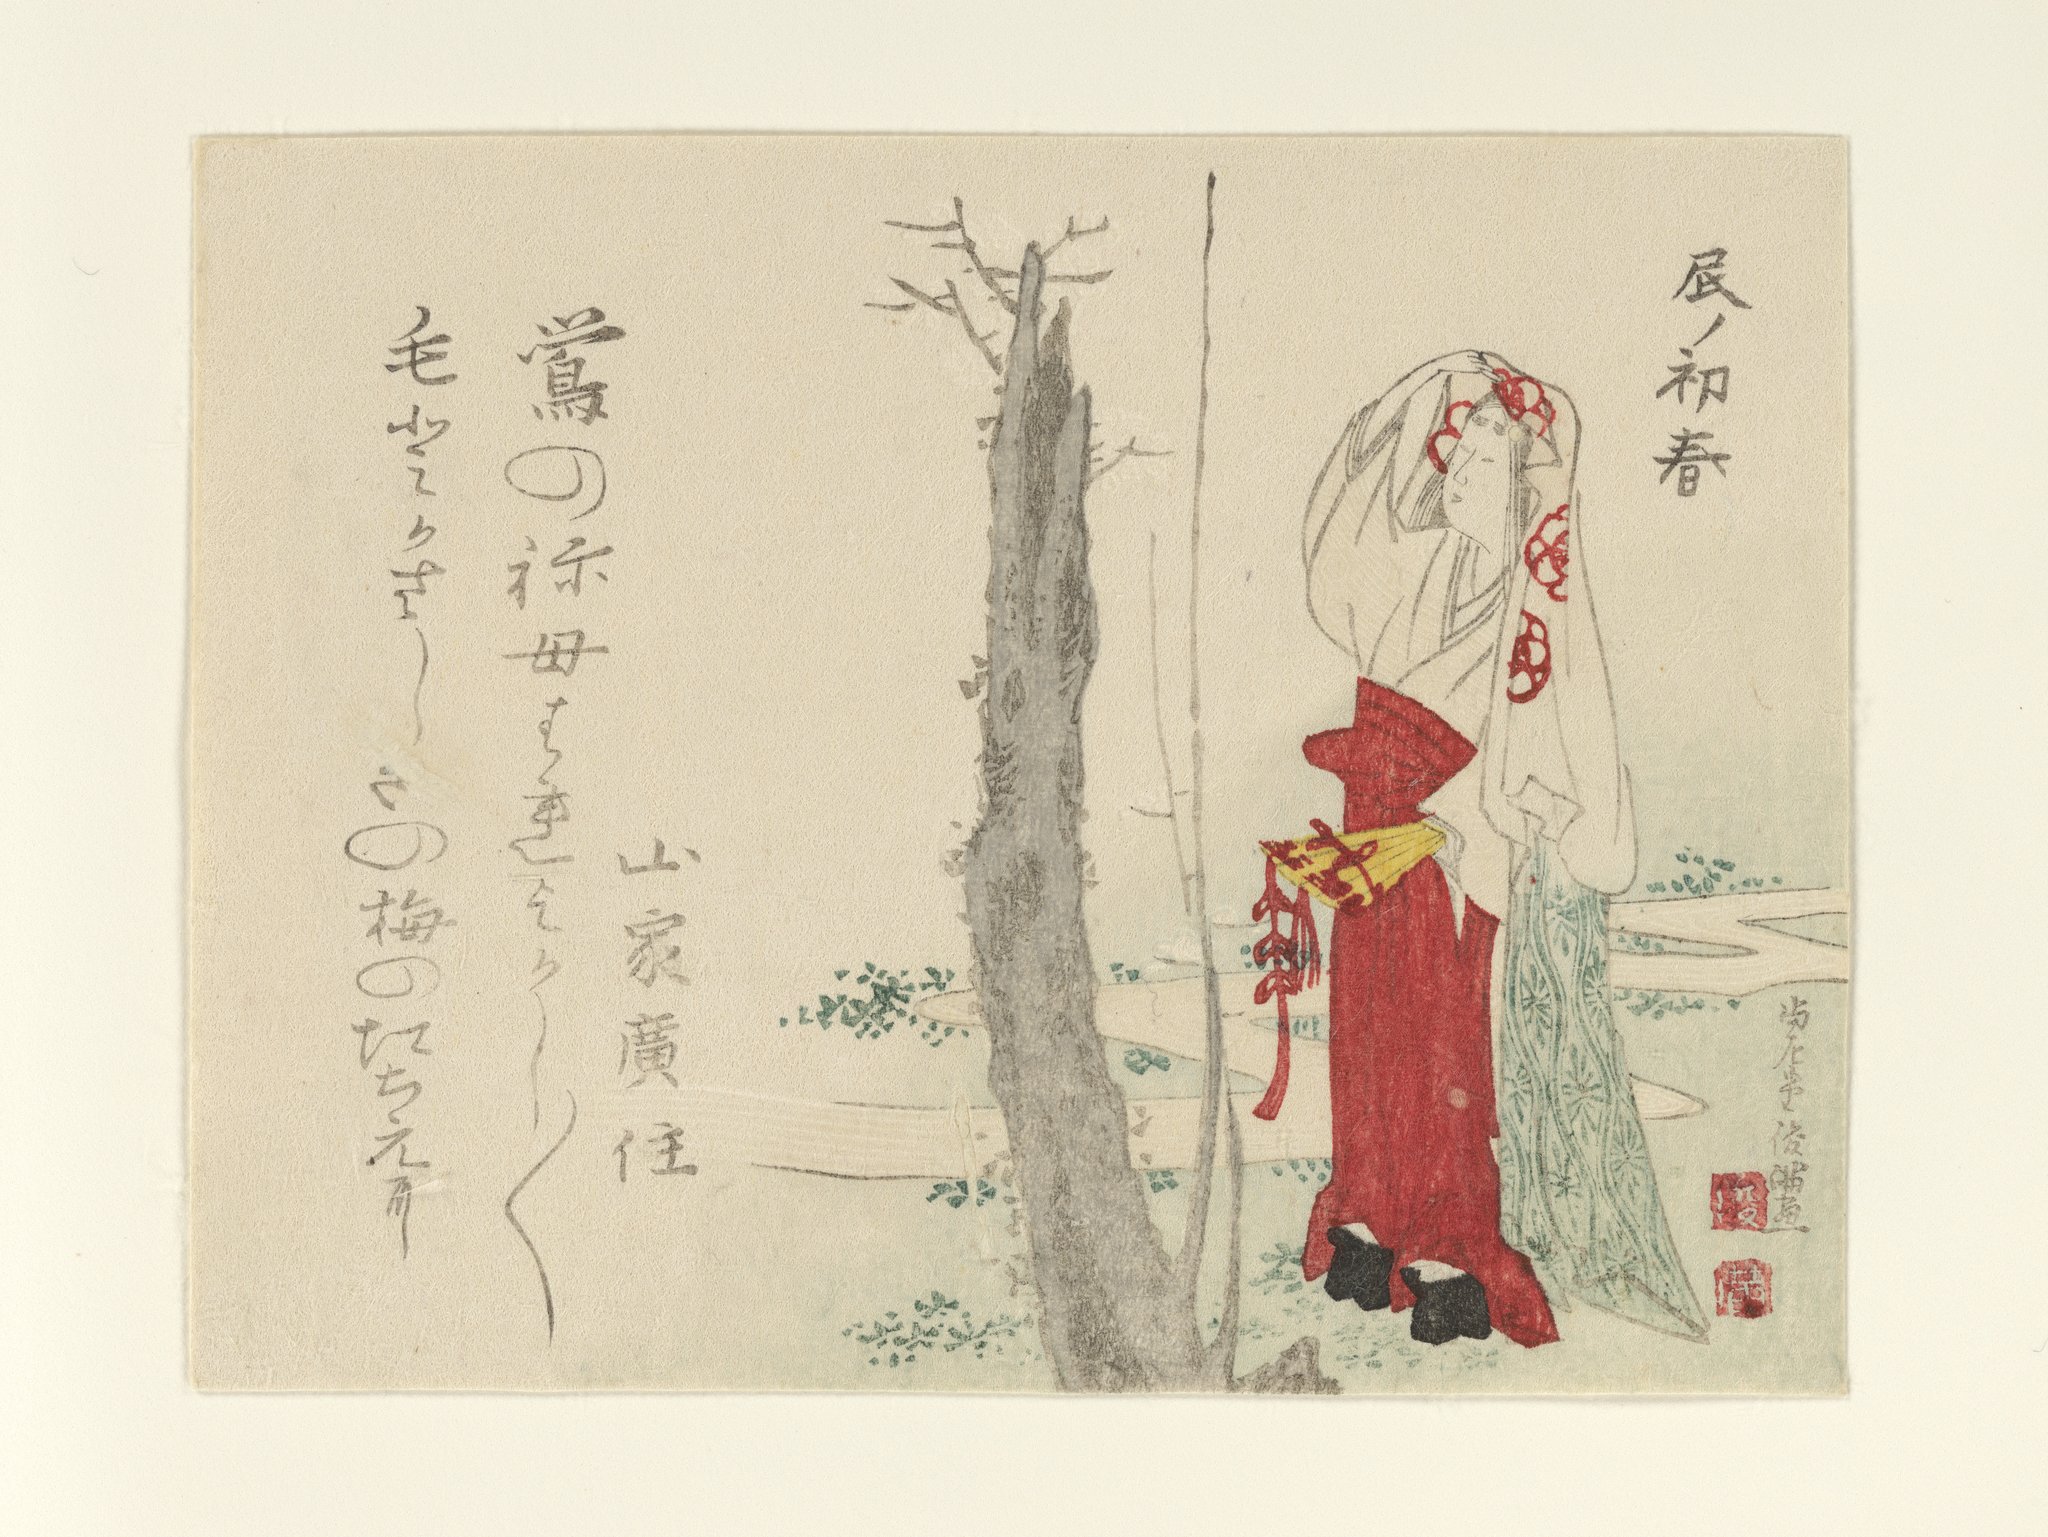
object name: print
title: Court Lady by Old Plum Tree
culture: japanese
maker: kubo shunman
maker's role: artist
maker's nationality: japanese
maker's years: 1757-1820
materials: ink, paper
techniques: surimono, woodblock print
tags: women,trees